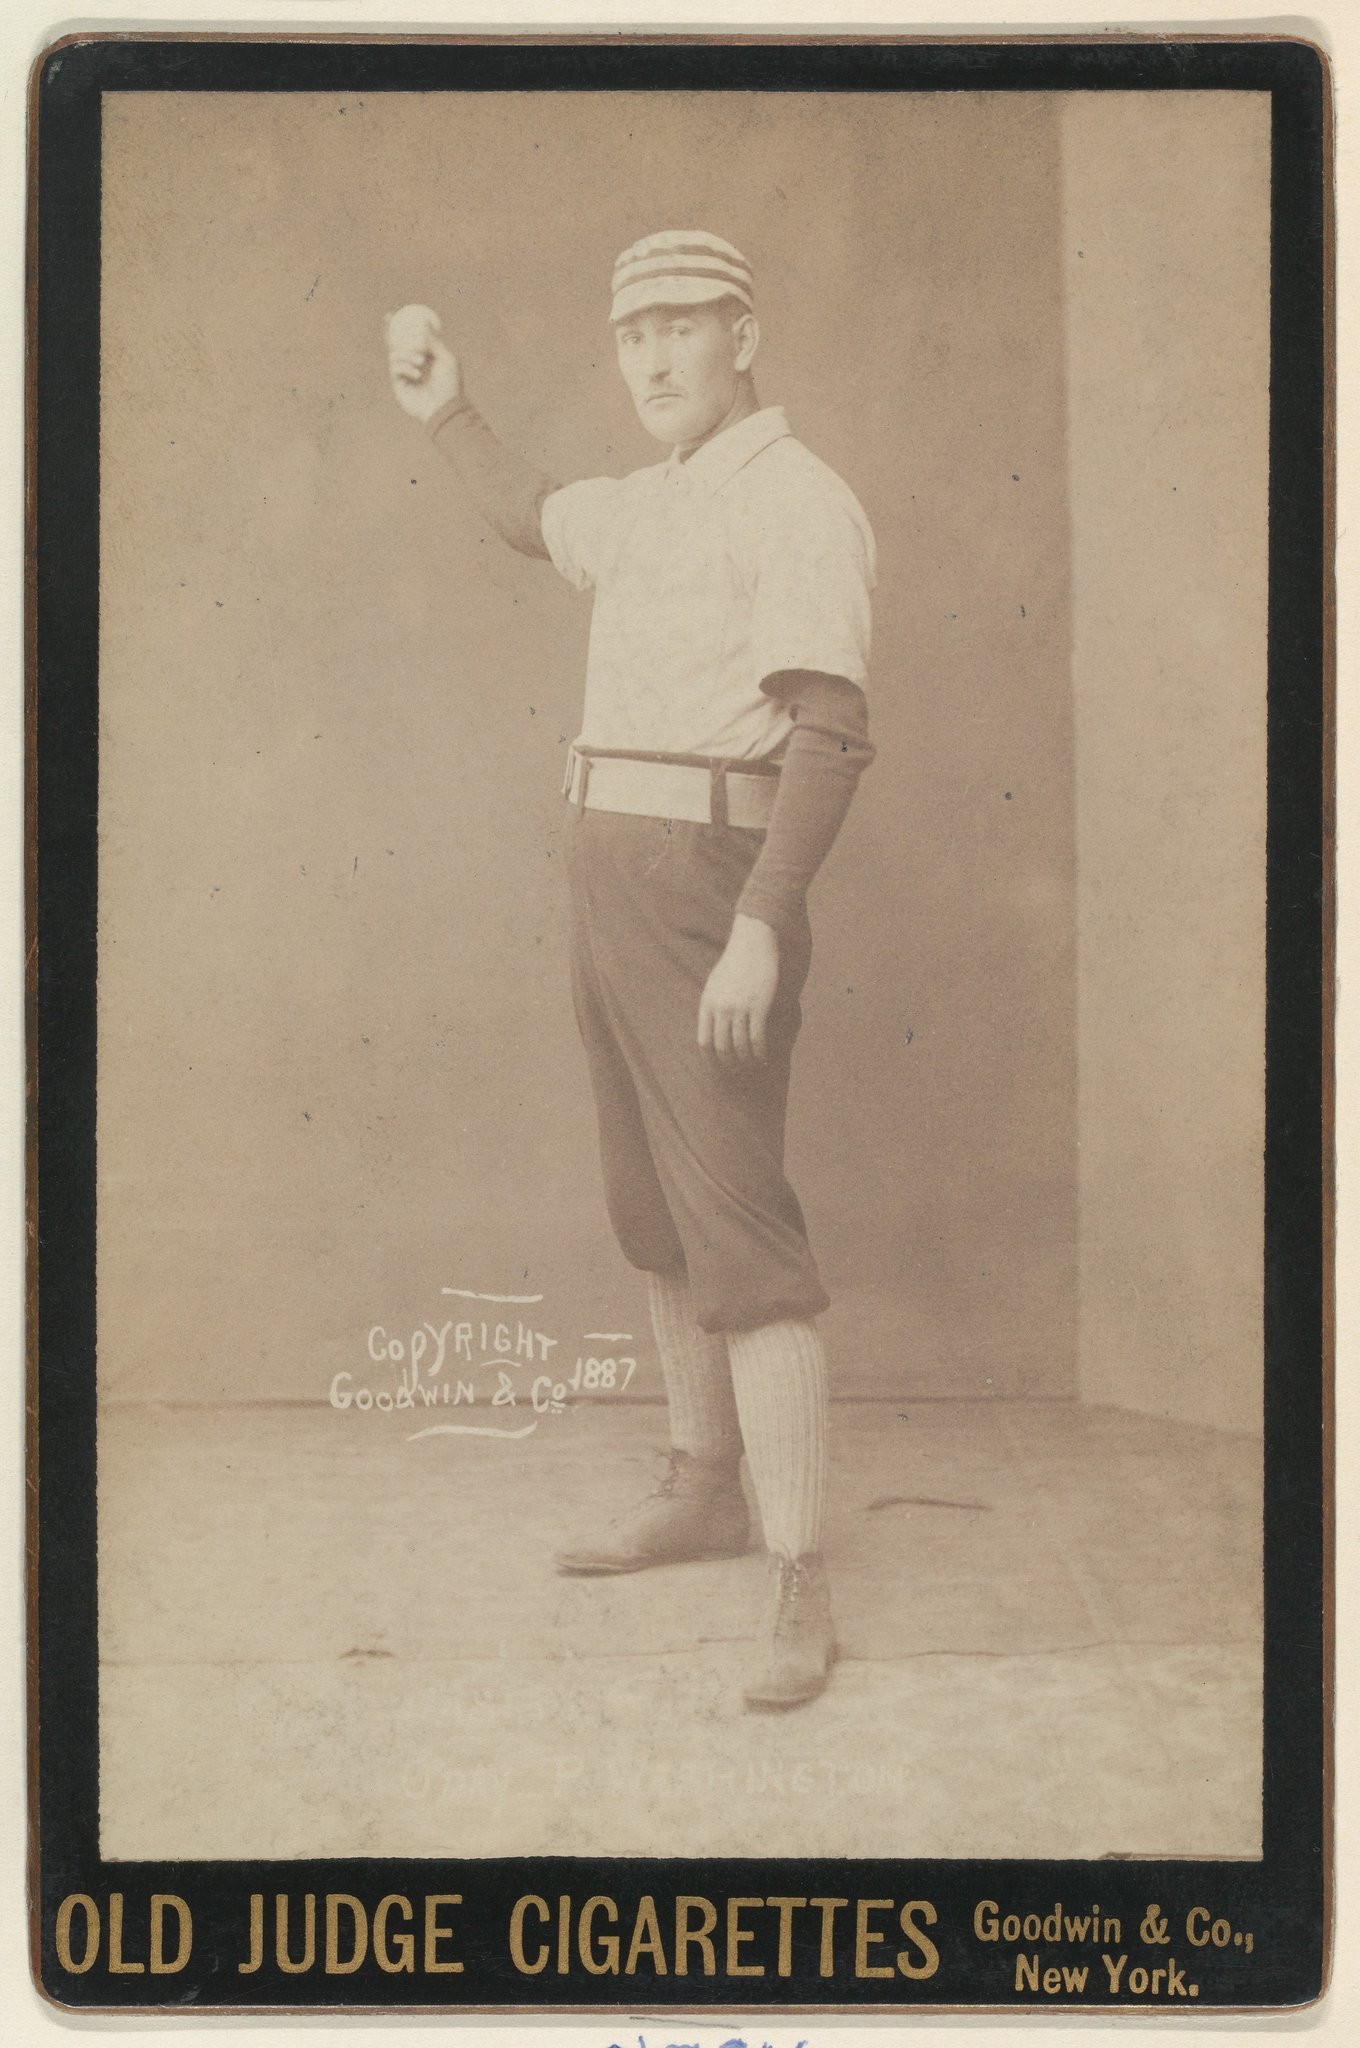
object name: baseball card, photograph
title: O'Day, Pitcher, Washington, from the series Old Judge Cigarettes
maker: goodwin & company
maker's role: publisher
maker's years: 1850-1950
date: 1887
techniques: albumen print, photography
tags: men,portraits,baseball,athletes